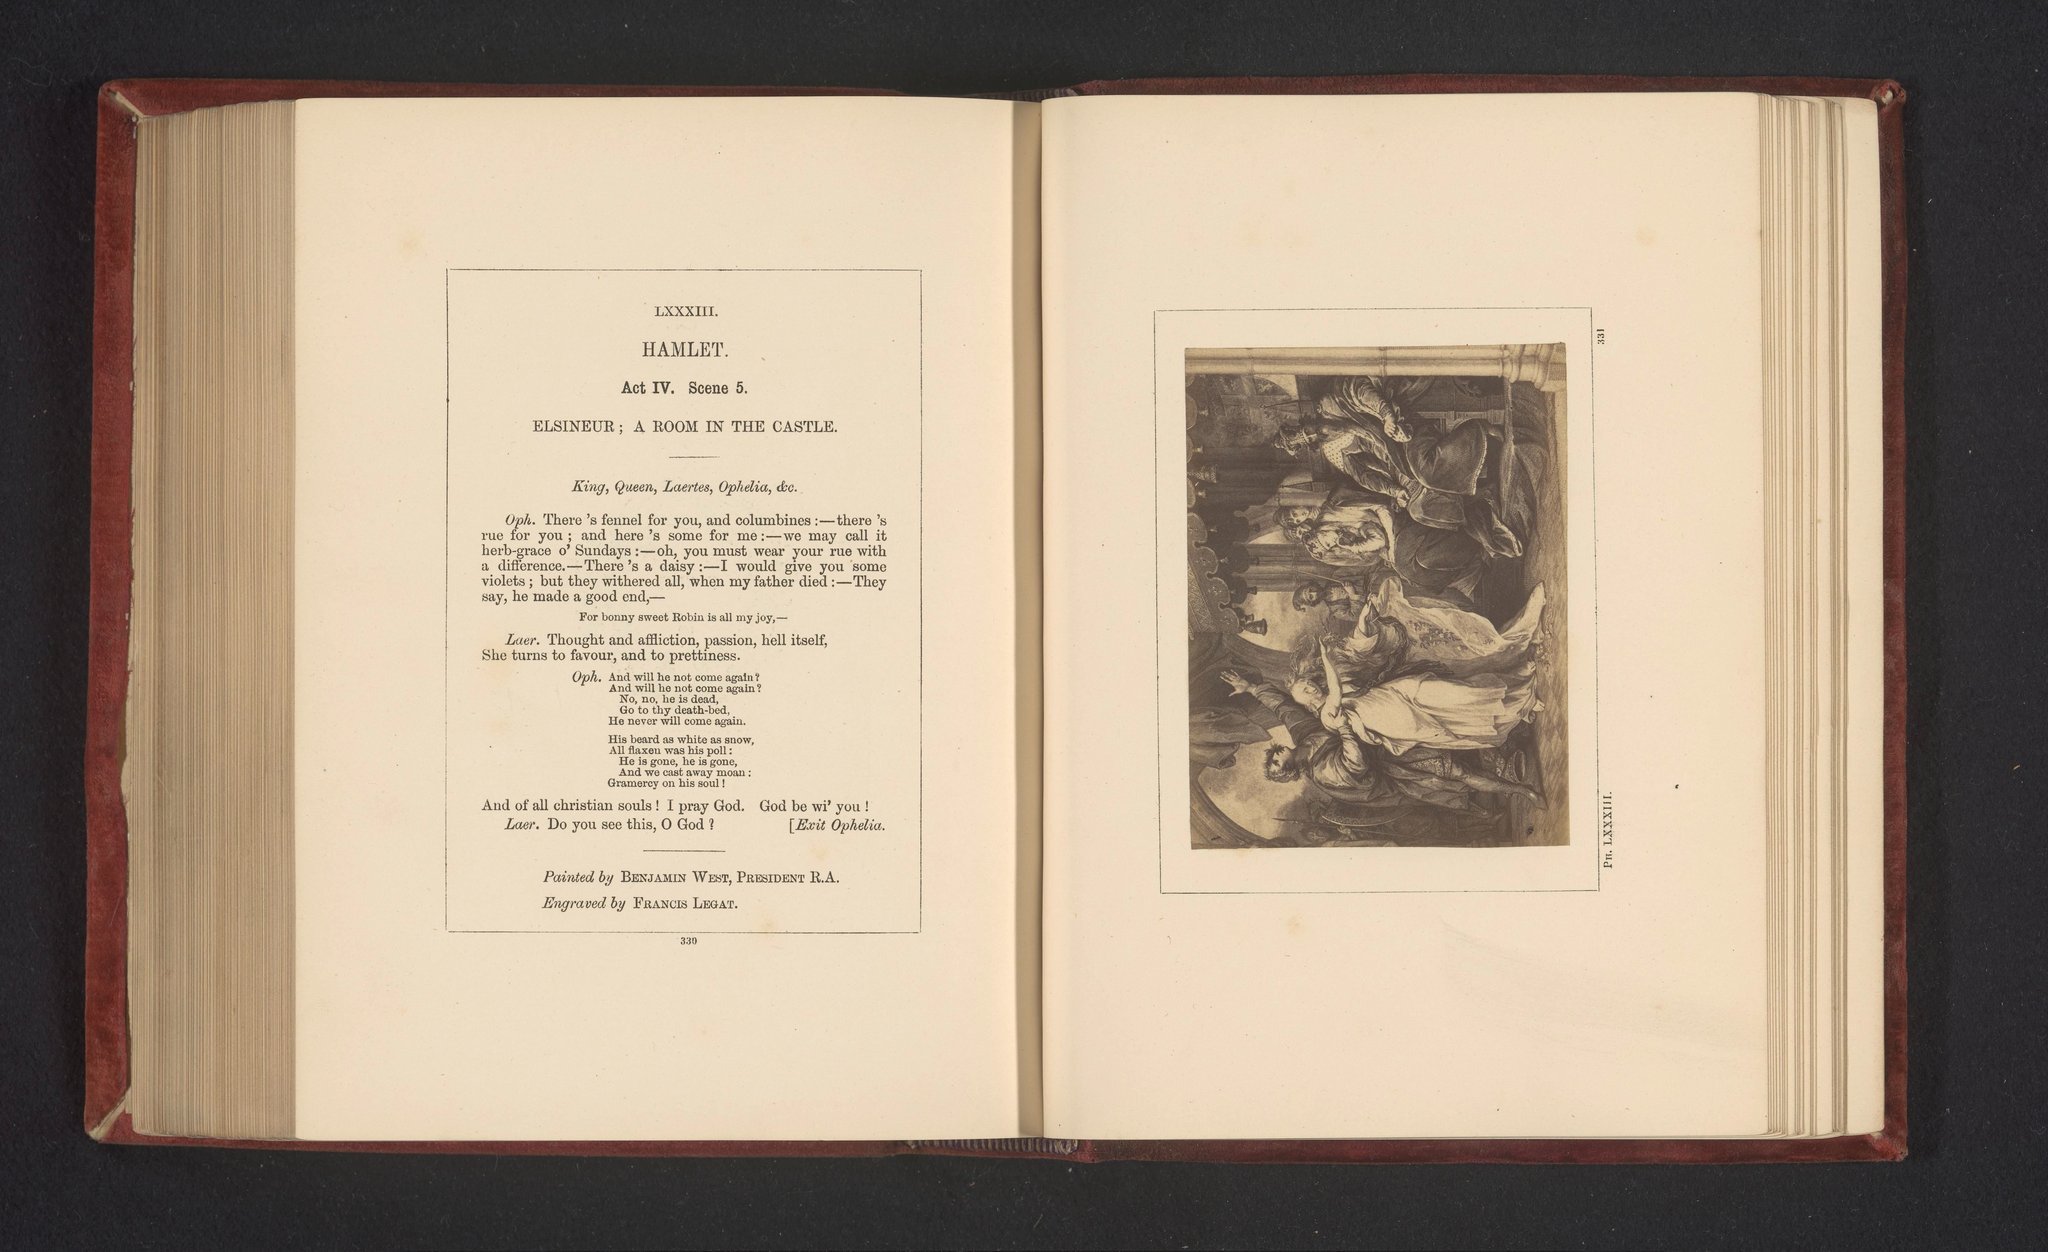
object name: reproduction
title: Fotoreproductie van een prent naar een schilderij door Benjamin West, voorstellend een scene uit Hamlet door William Shakespeare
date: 1854-1864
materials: photographic support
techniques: albumen print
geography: london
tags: ophelia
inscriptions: number: ‘Ph. LXXXIII. 331’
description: Te zien is akte IV, scene 5 met Ophelia en Laertes voor de koning en de koningin.